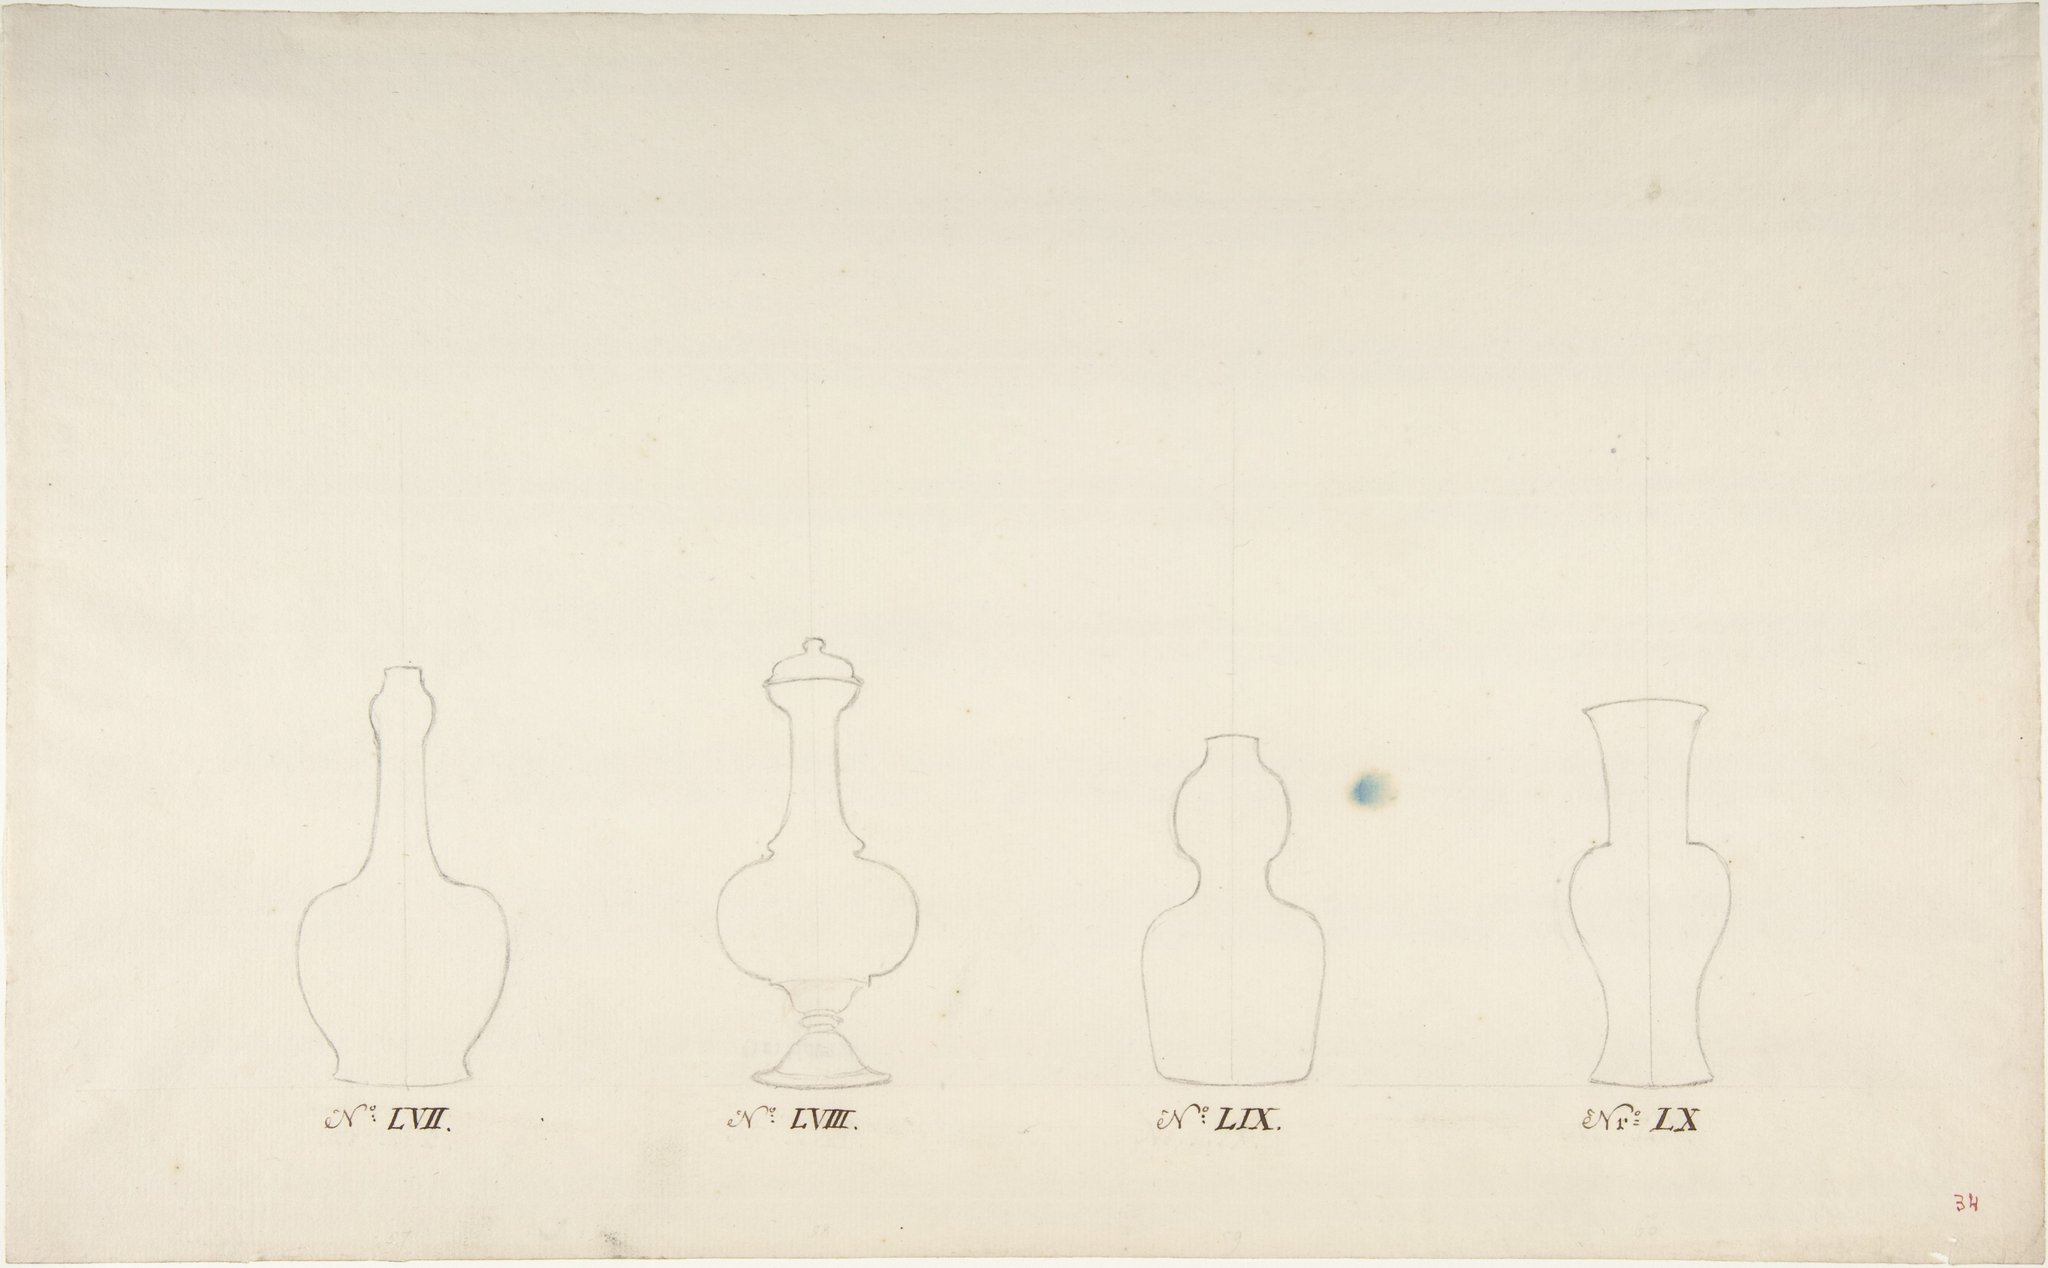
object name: drawing ornament architecture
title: Design for Four Vases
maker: anonymous, french, 18th century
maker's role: artist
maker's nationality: french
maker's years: 1700-1800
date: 1770-1785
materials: chalk, ink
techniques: pen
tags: vases